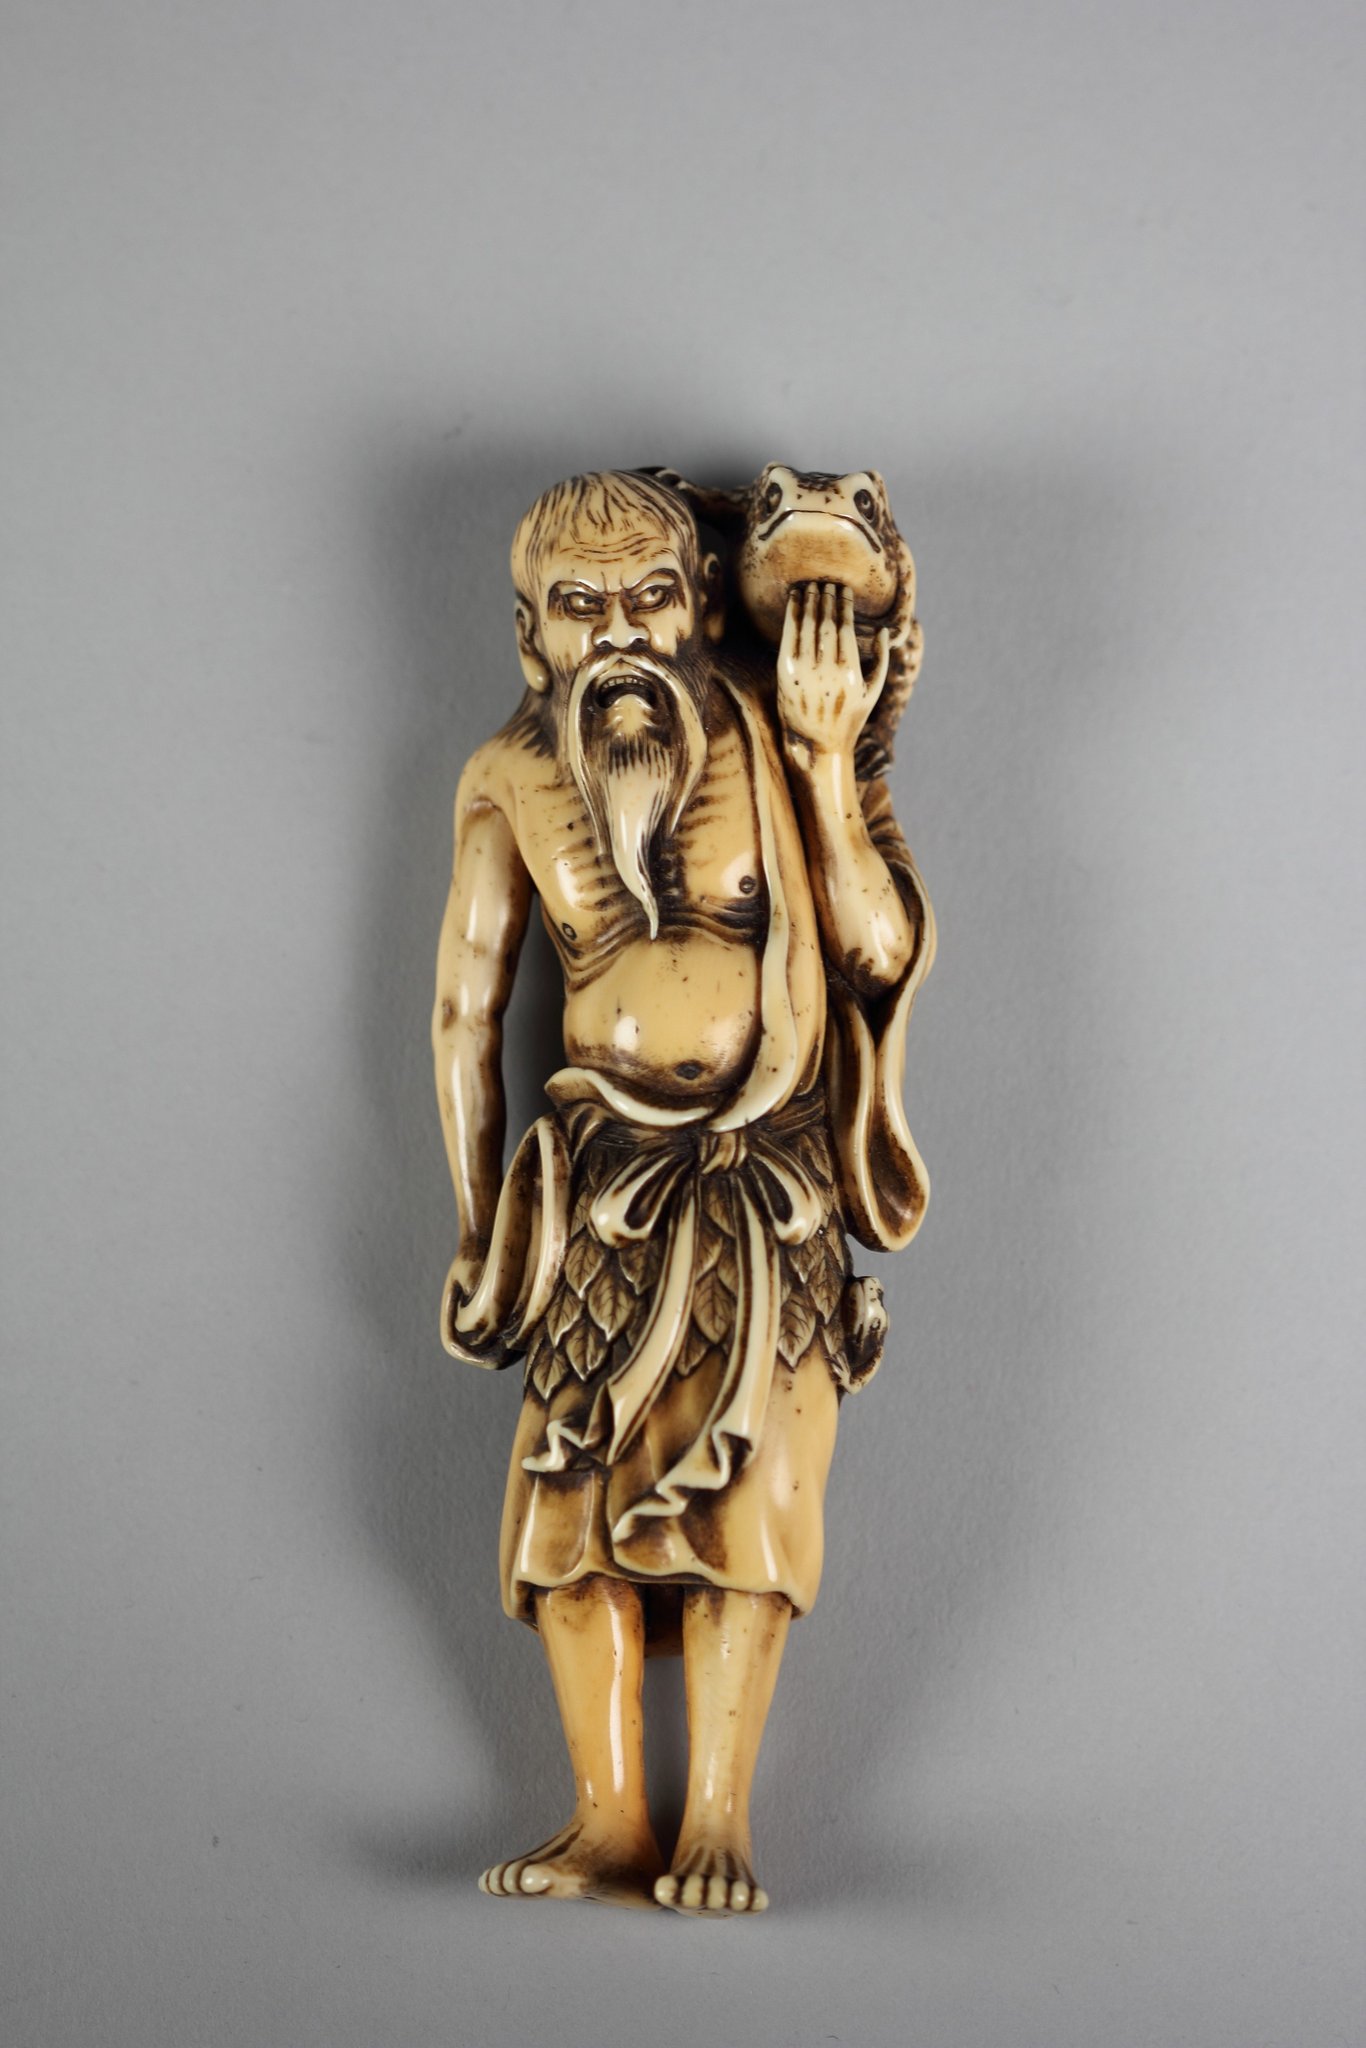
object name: netsuke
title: Gama Sennin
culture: japanese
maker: shūzan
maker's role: artist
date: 1767-1833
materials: ivory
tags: men